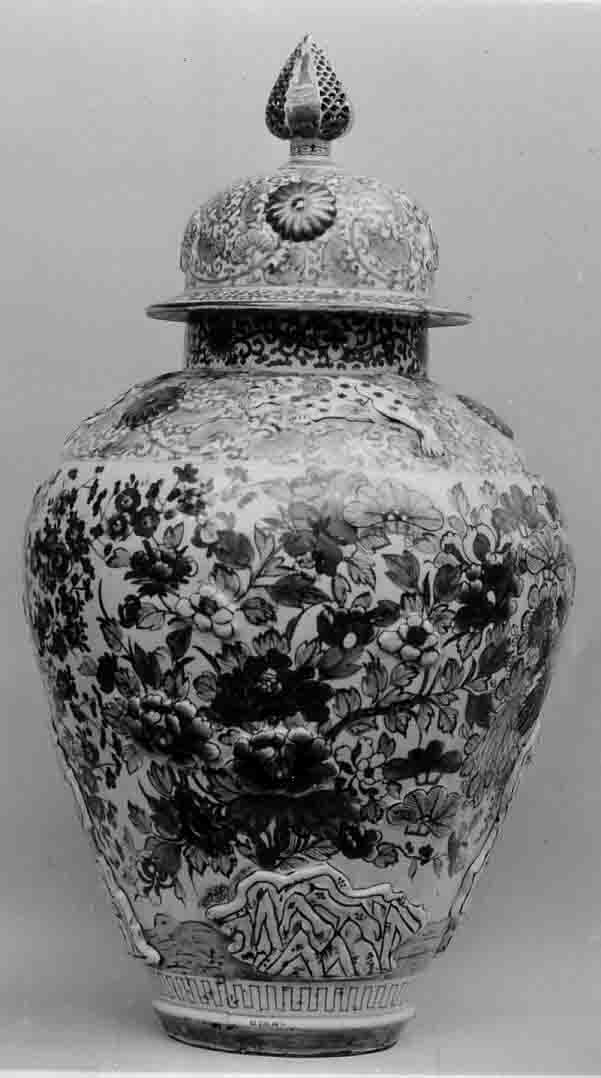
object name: vase with lid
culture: japanese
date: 1701-1800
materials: enamel, porcelain